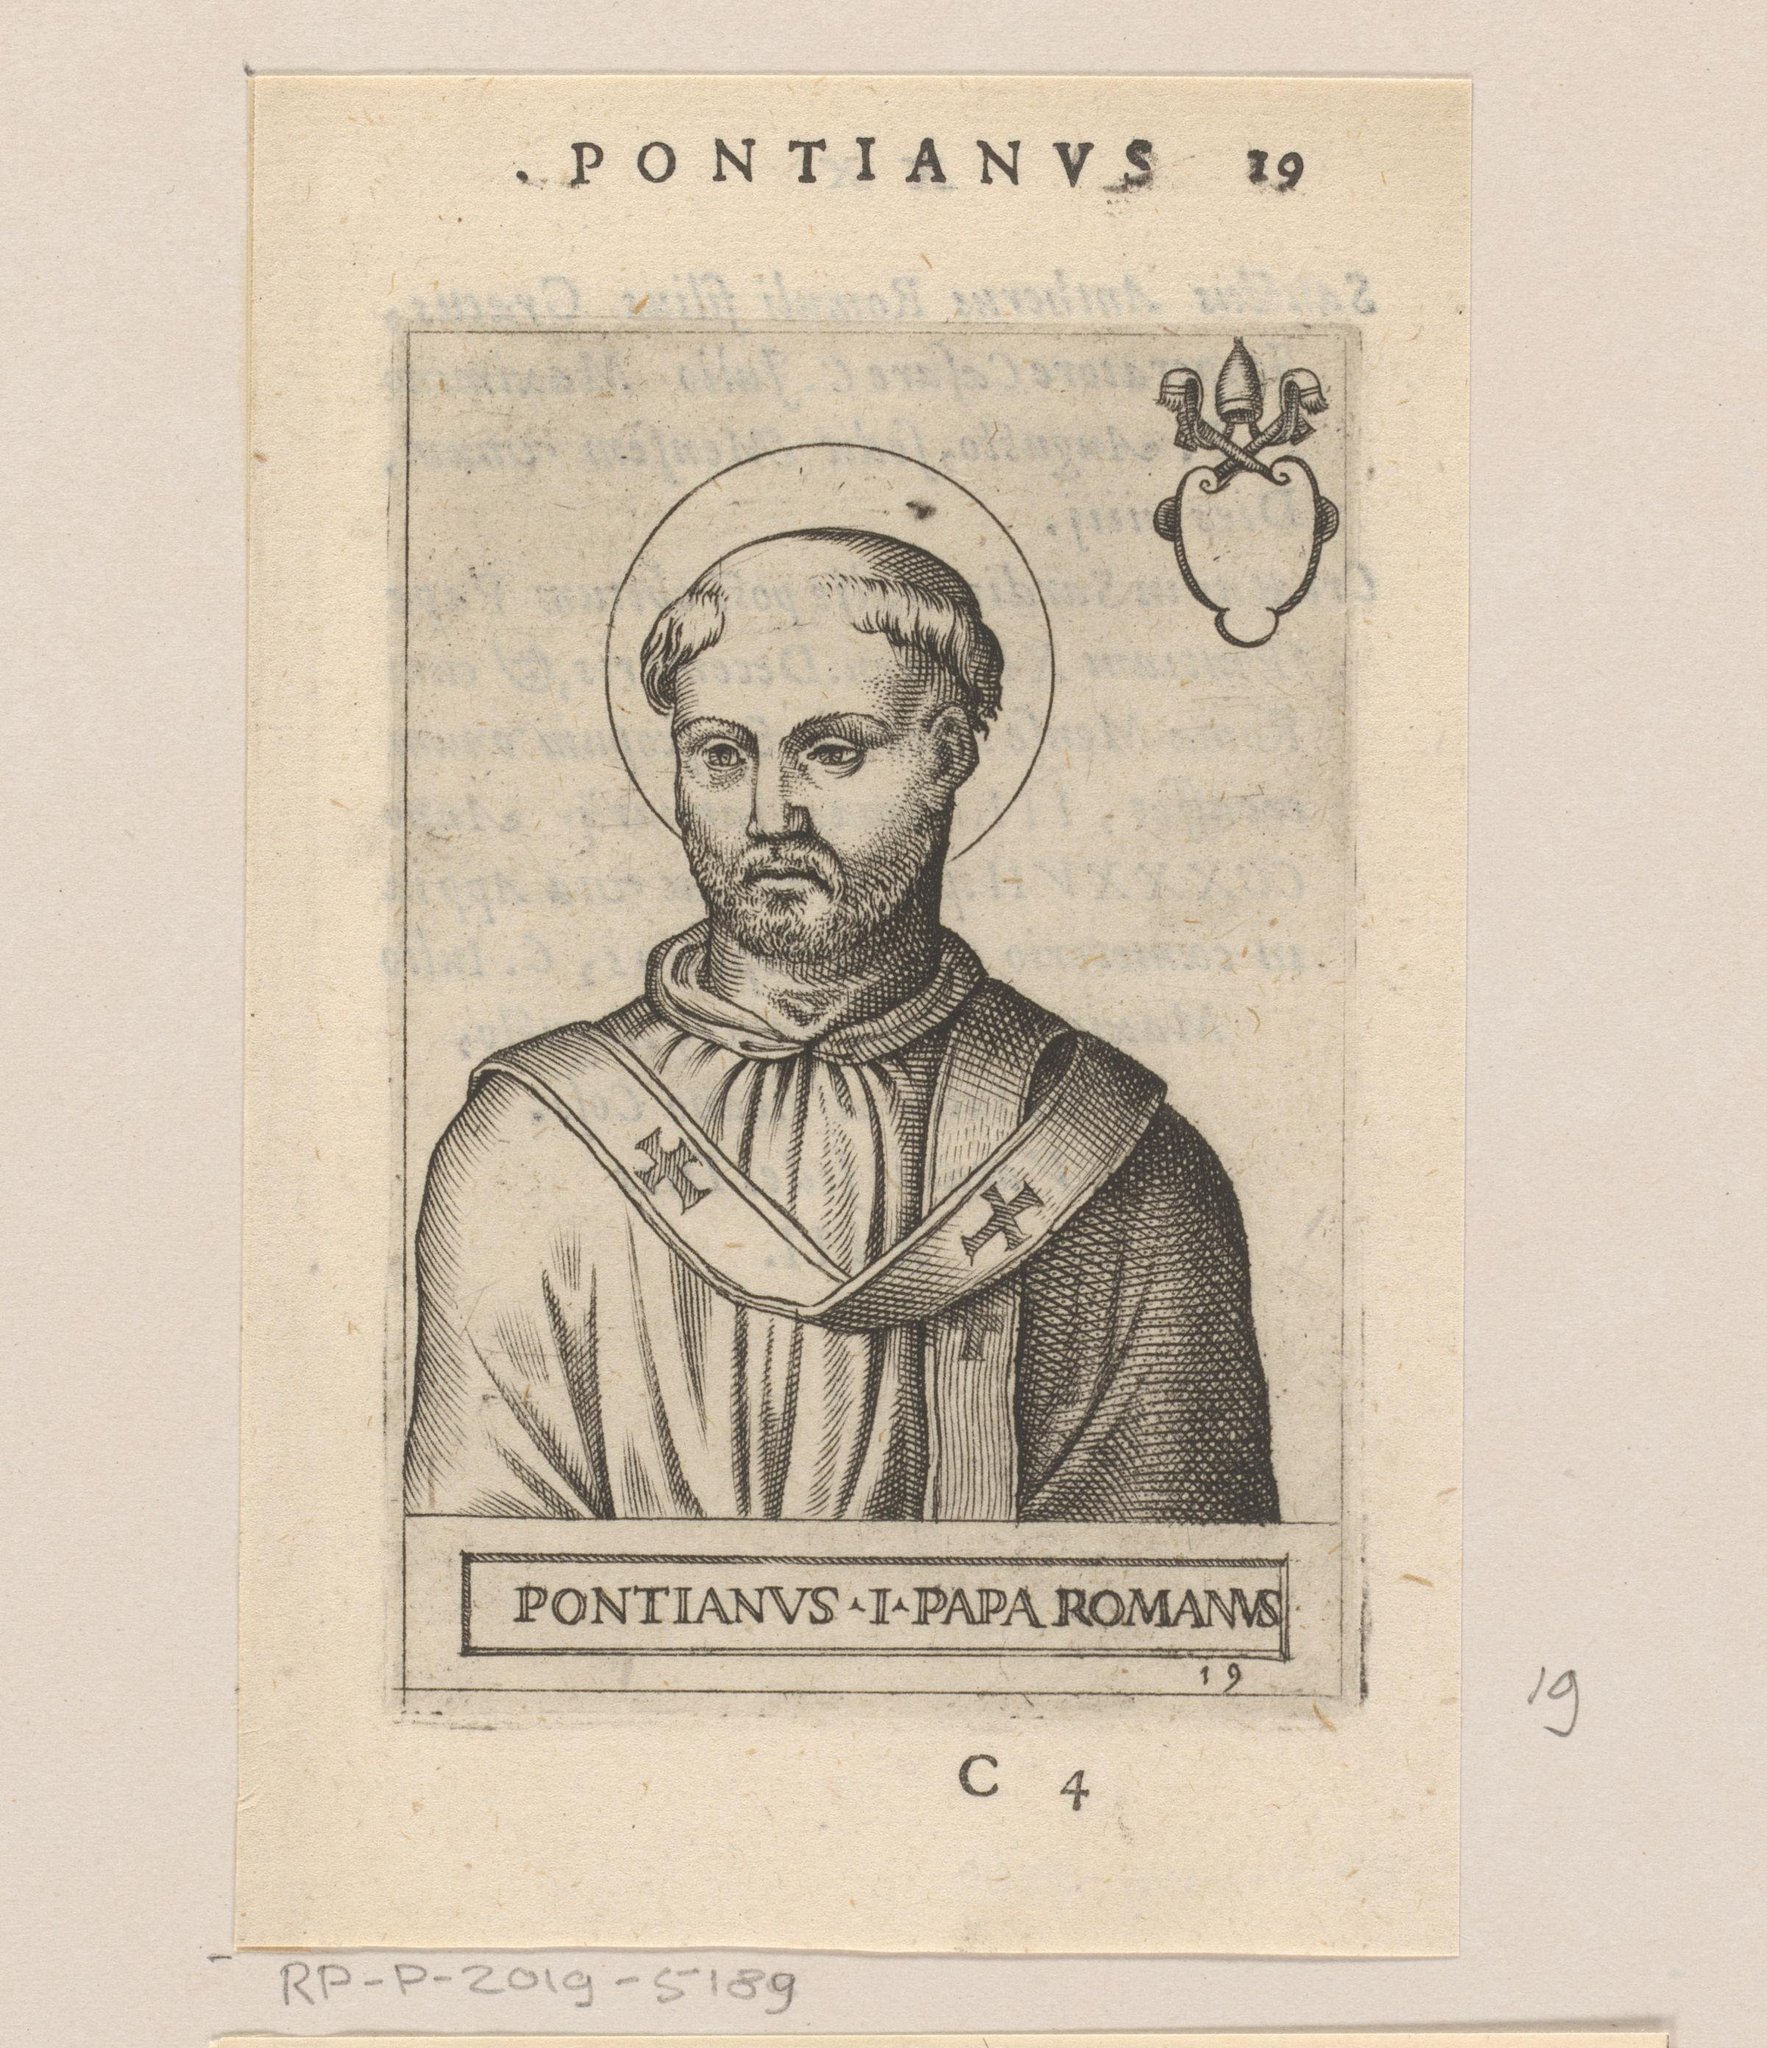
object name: book illustration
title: Pontianus I Papa Romanus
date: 1595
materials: paper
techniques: engraving, letterpress printing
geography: rome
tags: historical persons, pope, armorial bearing, heraldry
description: Prent uit: Cavalieri, Giovanni Battista de'. Effigies pontificum romanorum cum eorum vitis (...). Rome: Bartolomeo Bonfadino, 1595. Prent voor het eerst verschenen in: Cavalieri, Giovanni Battista de'. Pontificum romanorum effigies (...). Rome: Domenico Basa en Francesco Zanetti, 1580. Prent ook gebruikt in latere publicaties.